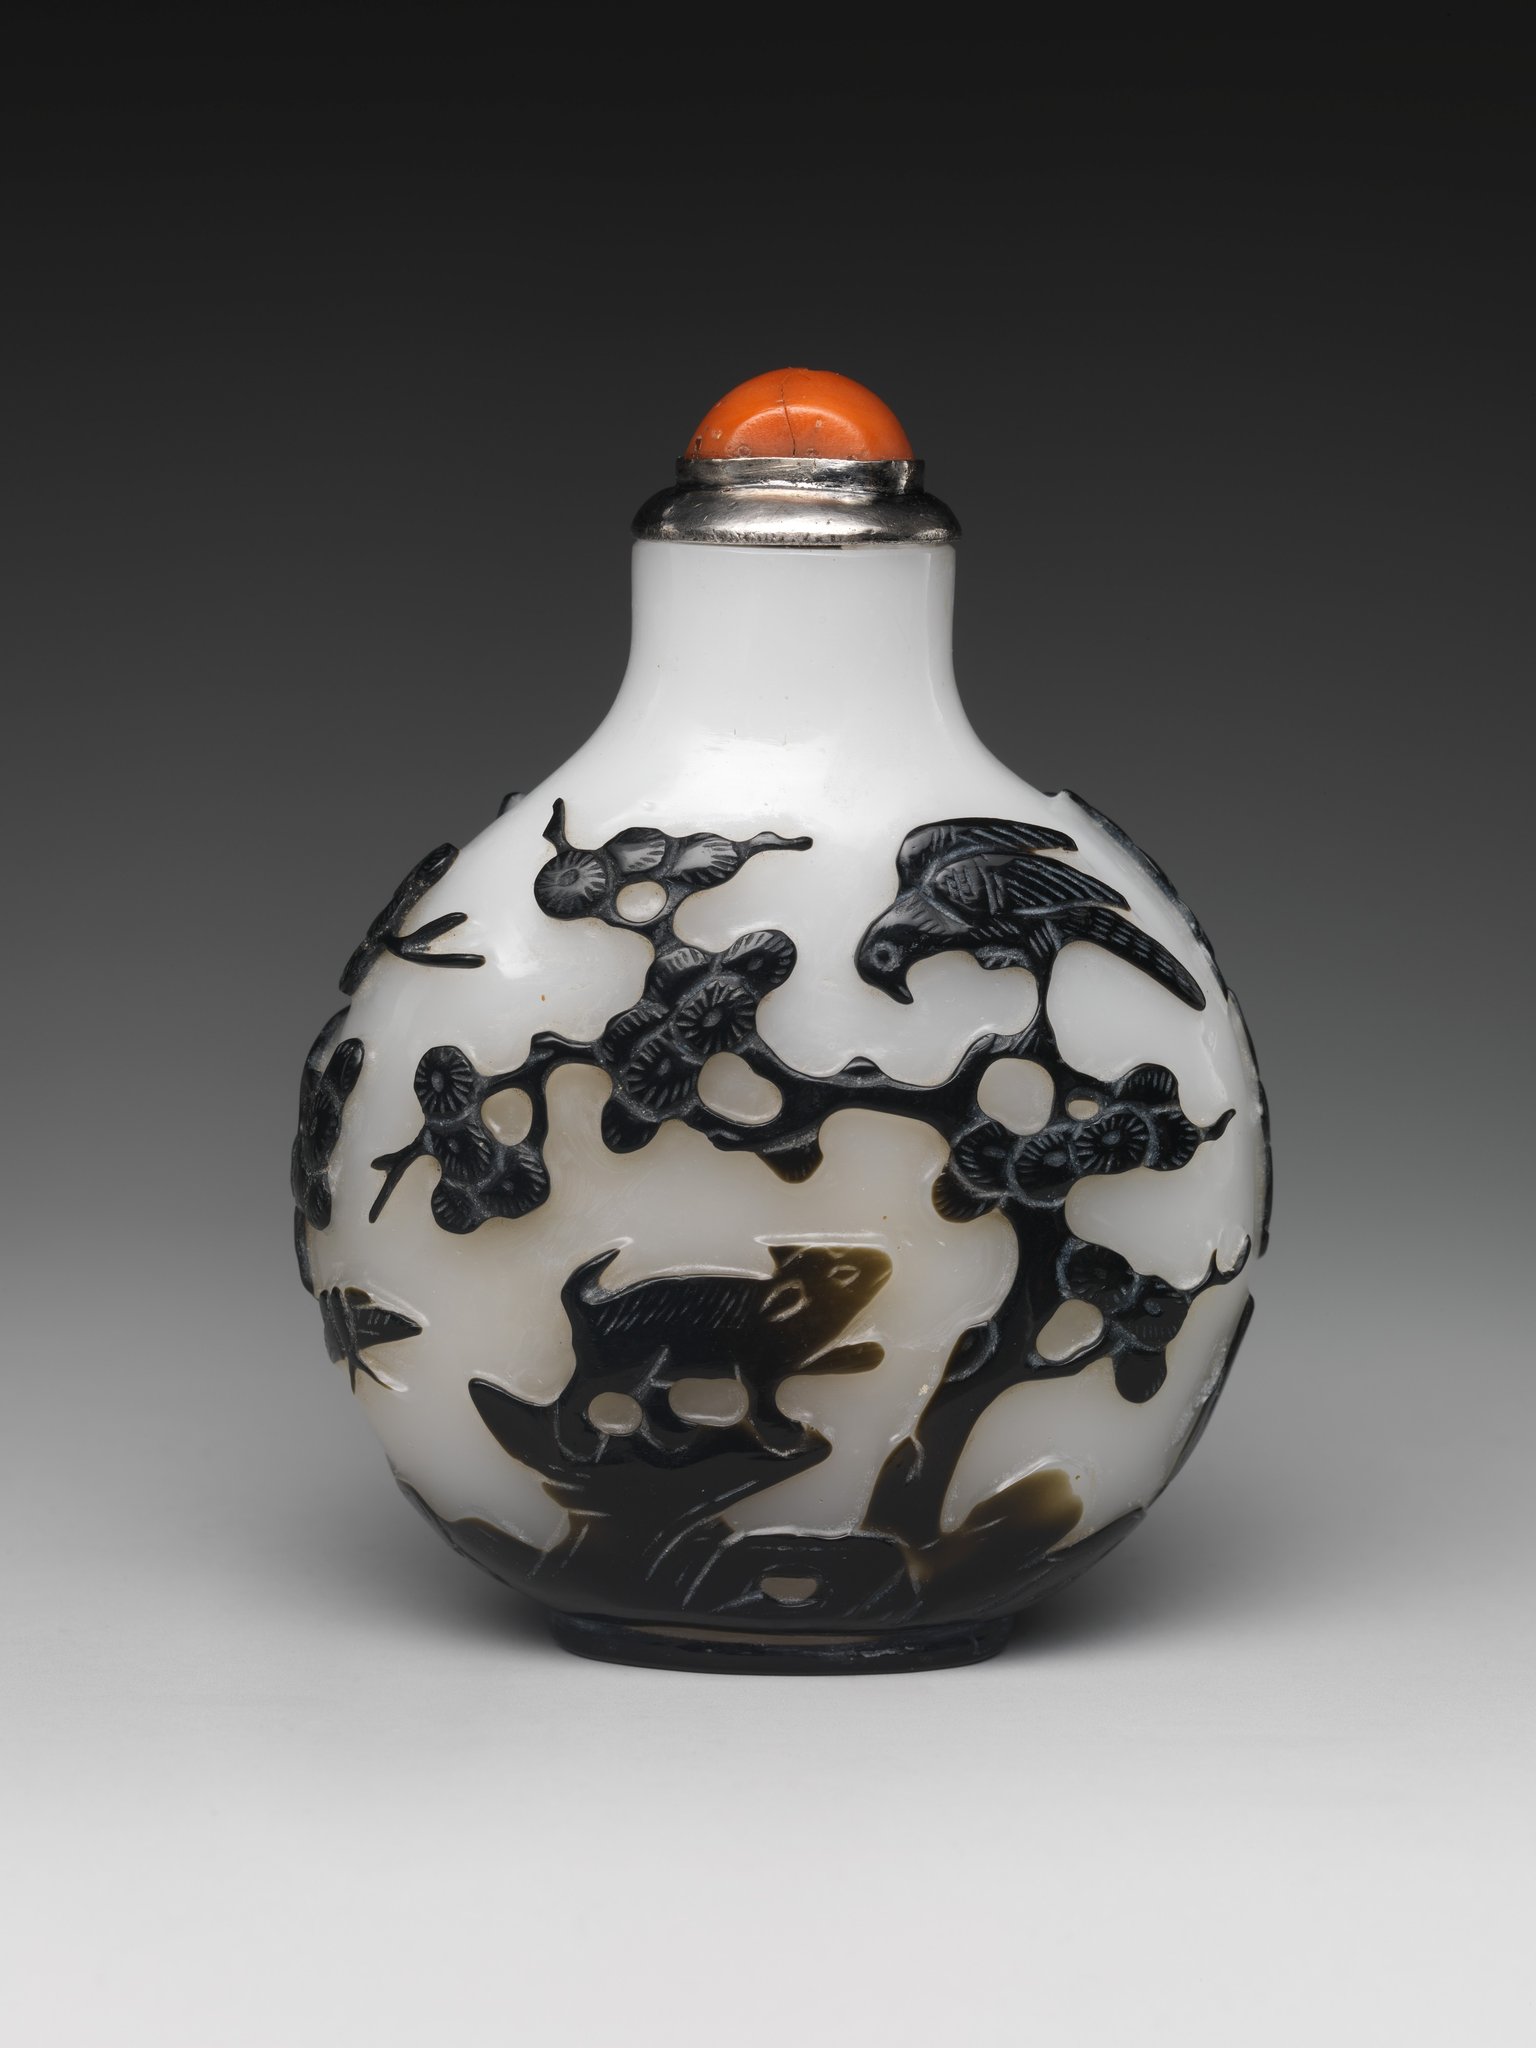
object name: snuff bottle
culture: chinese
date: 1751-1800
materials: coral, glass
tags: animals,birds